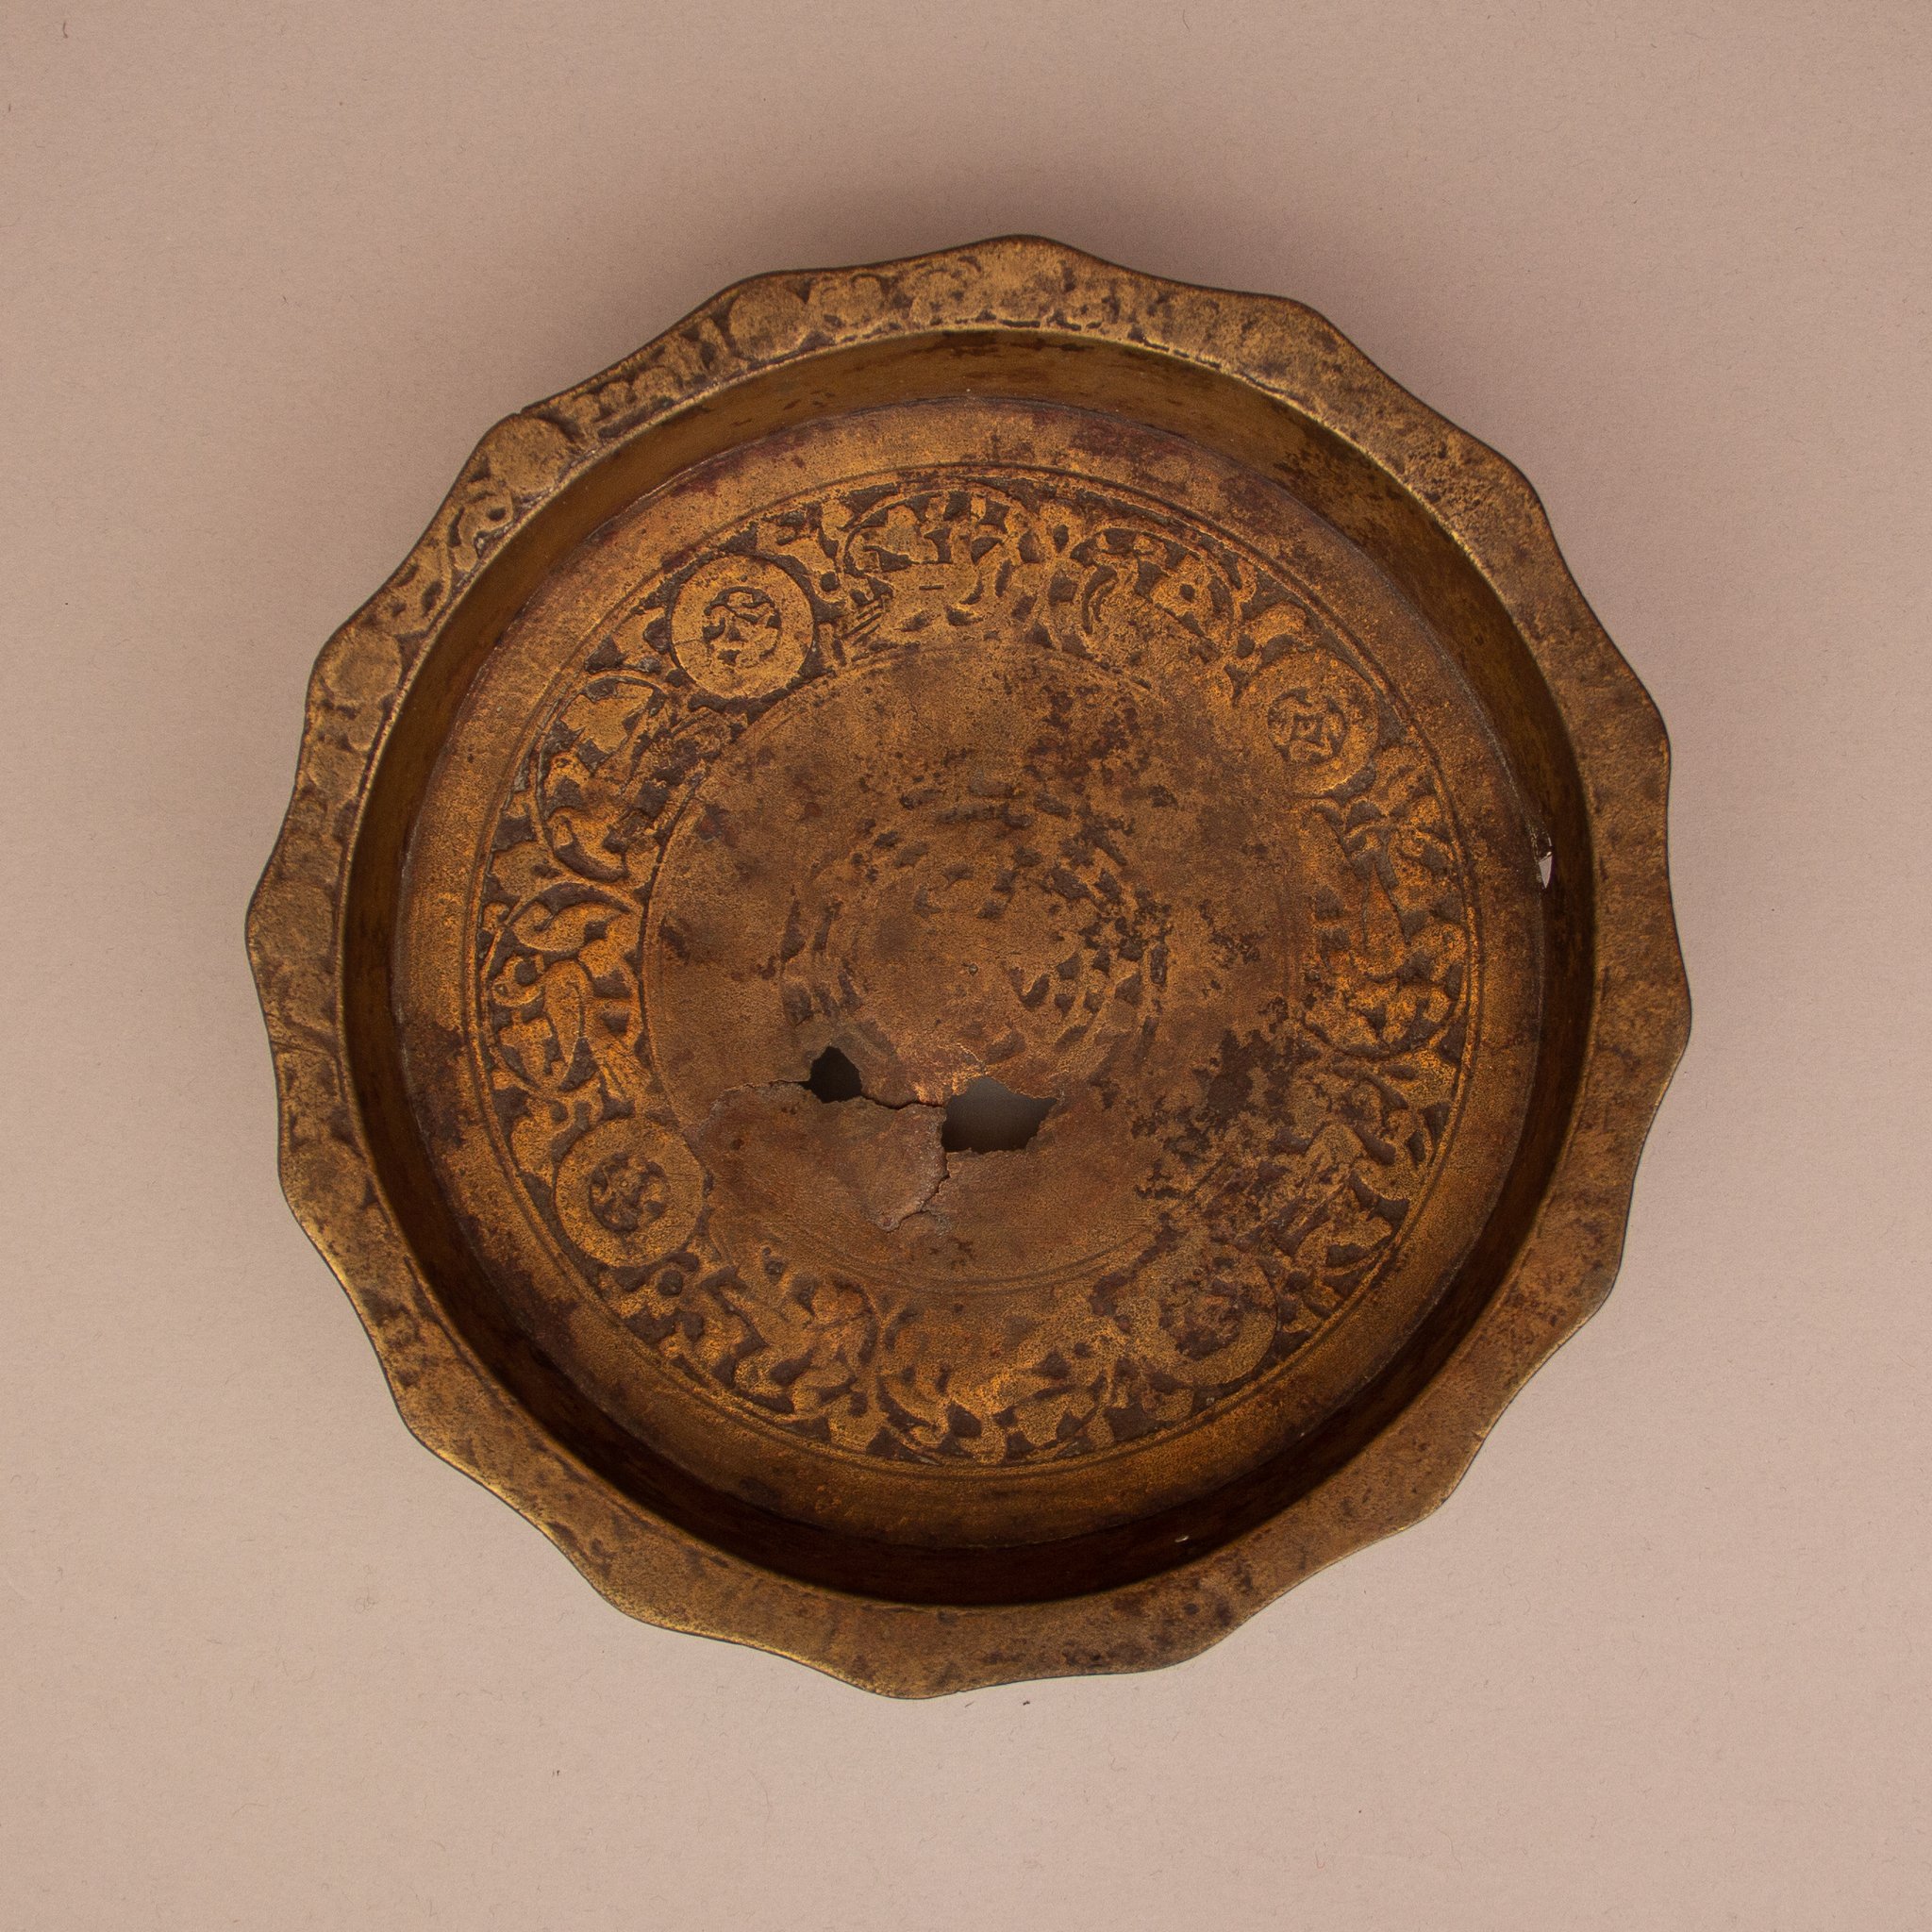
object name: incense burner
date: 1101-1200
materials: bronze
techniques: casting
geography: iran